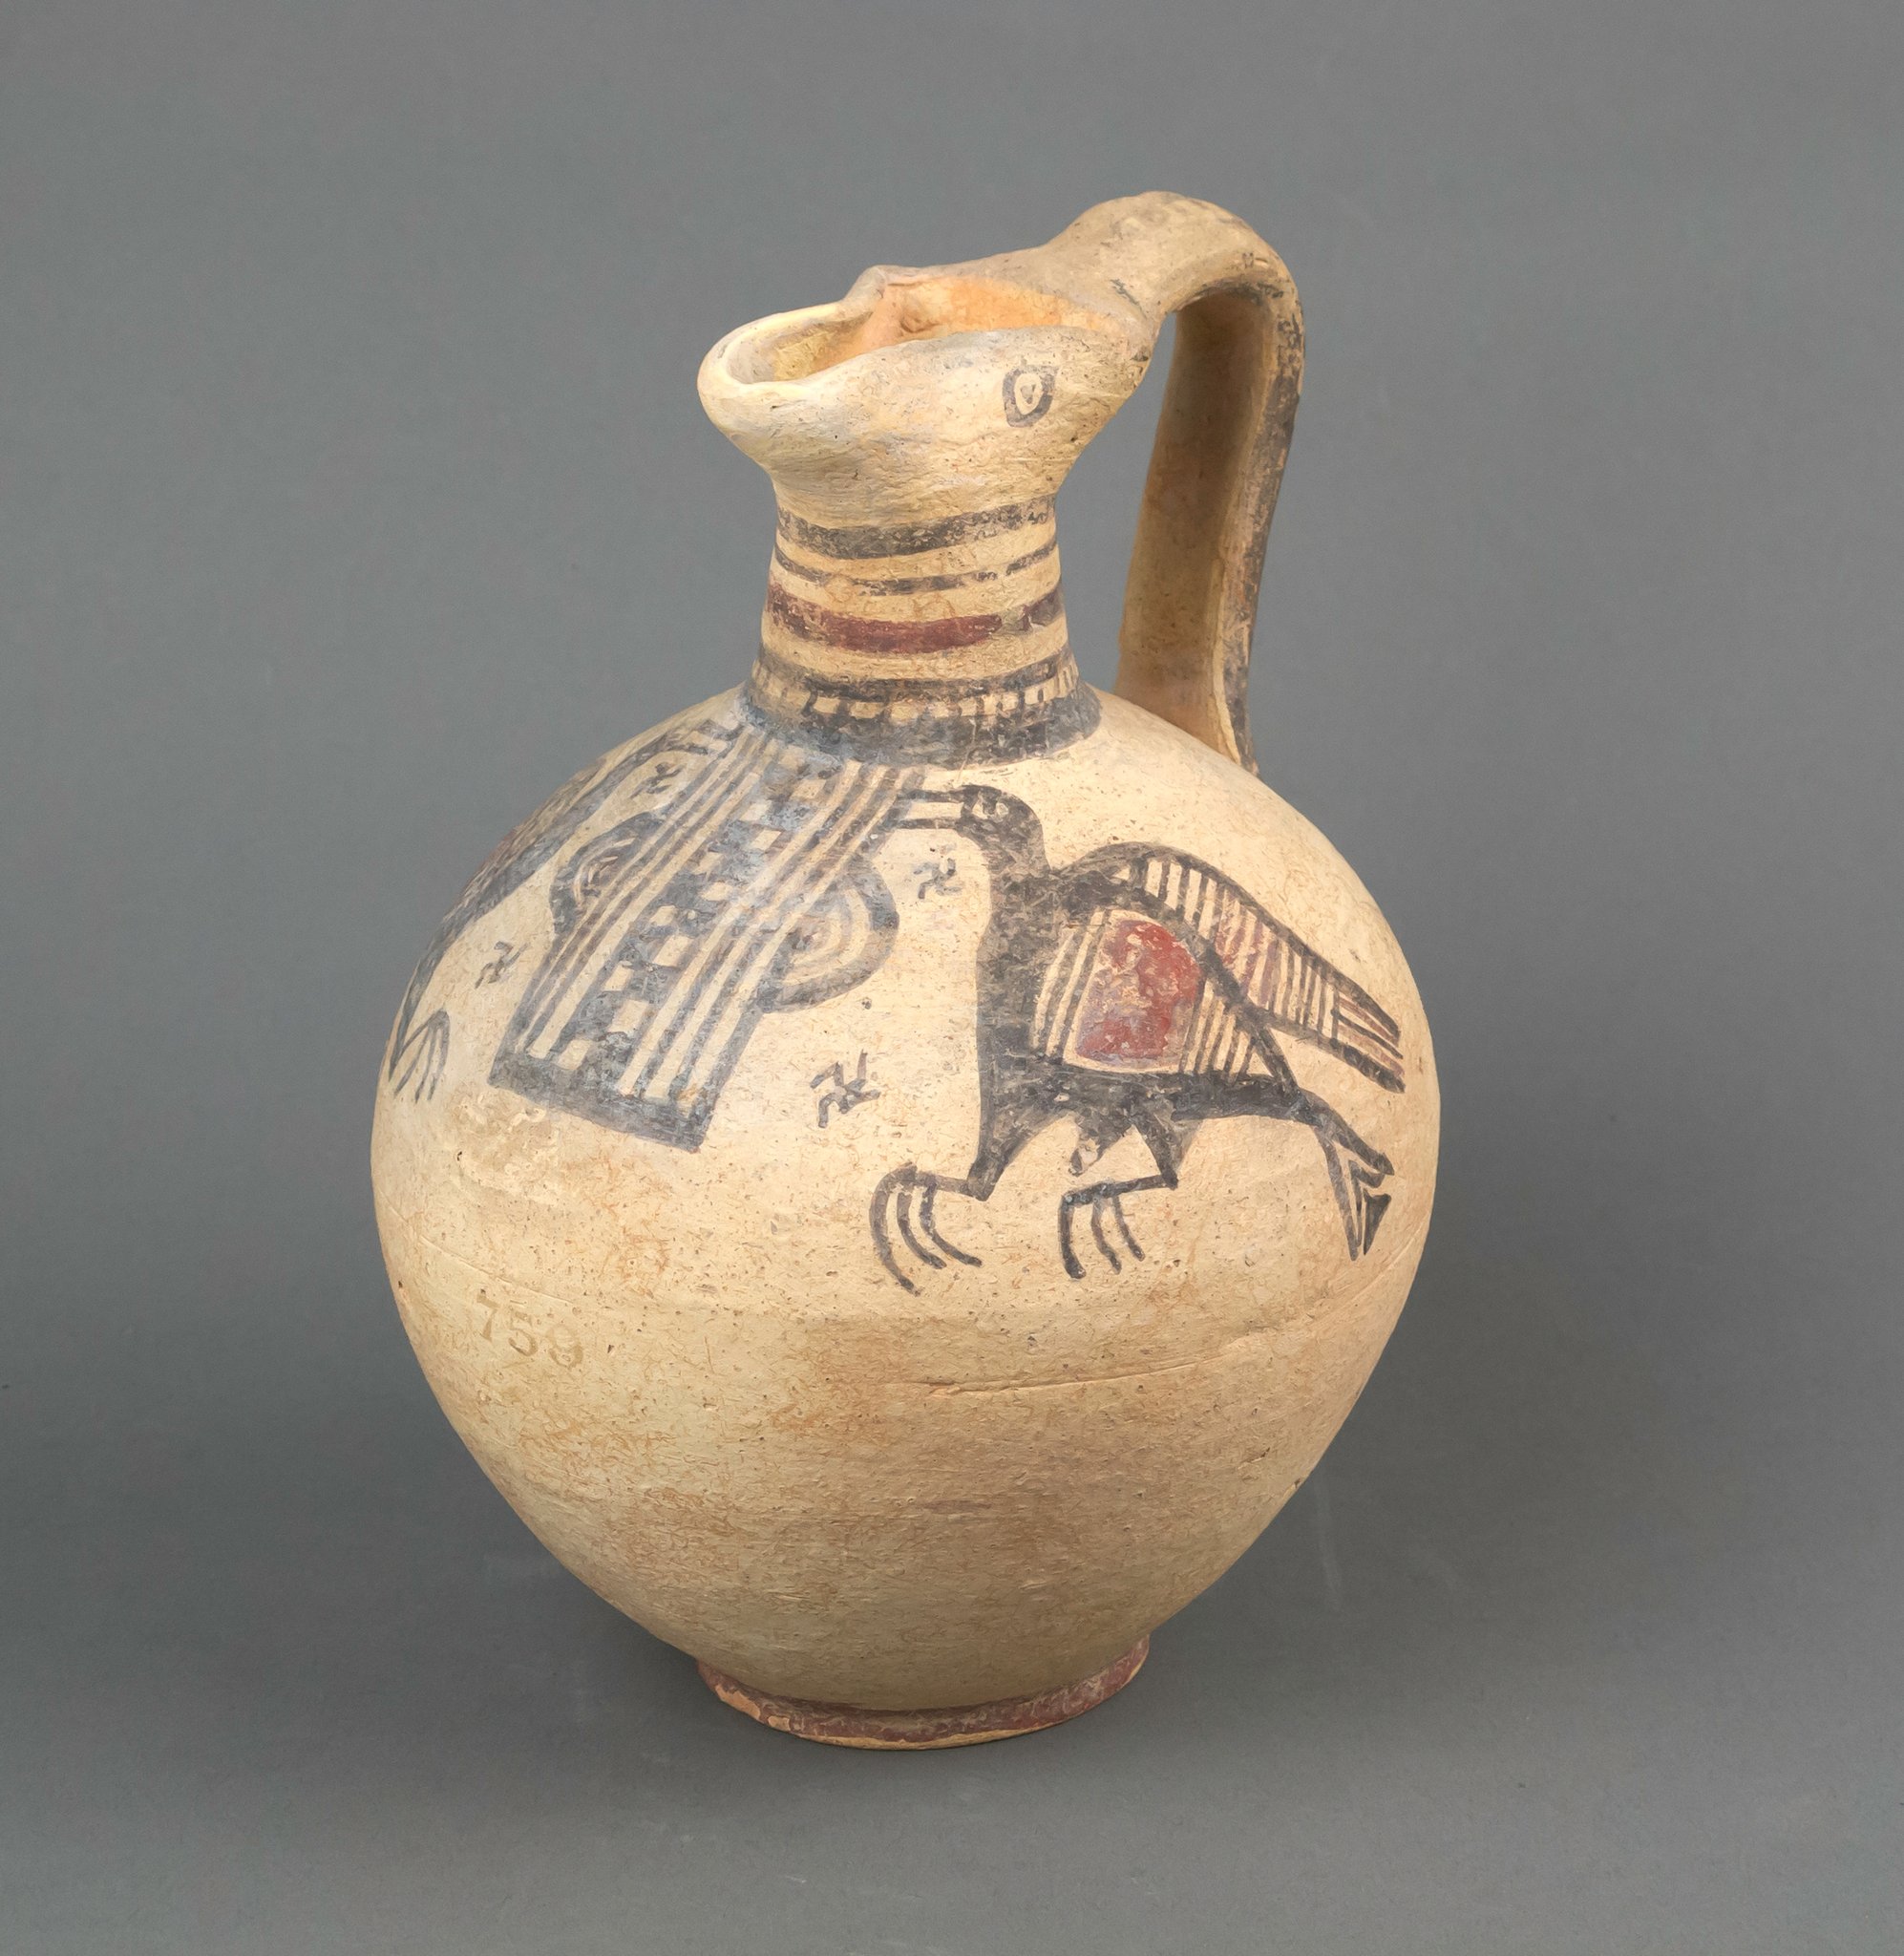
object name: jug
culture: cypriot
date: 750-600 BCE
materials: terracotta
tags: birds